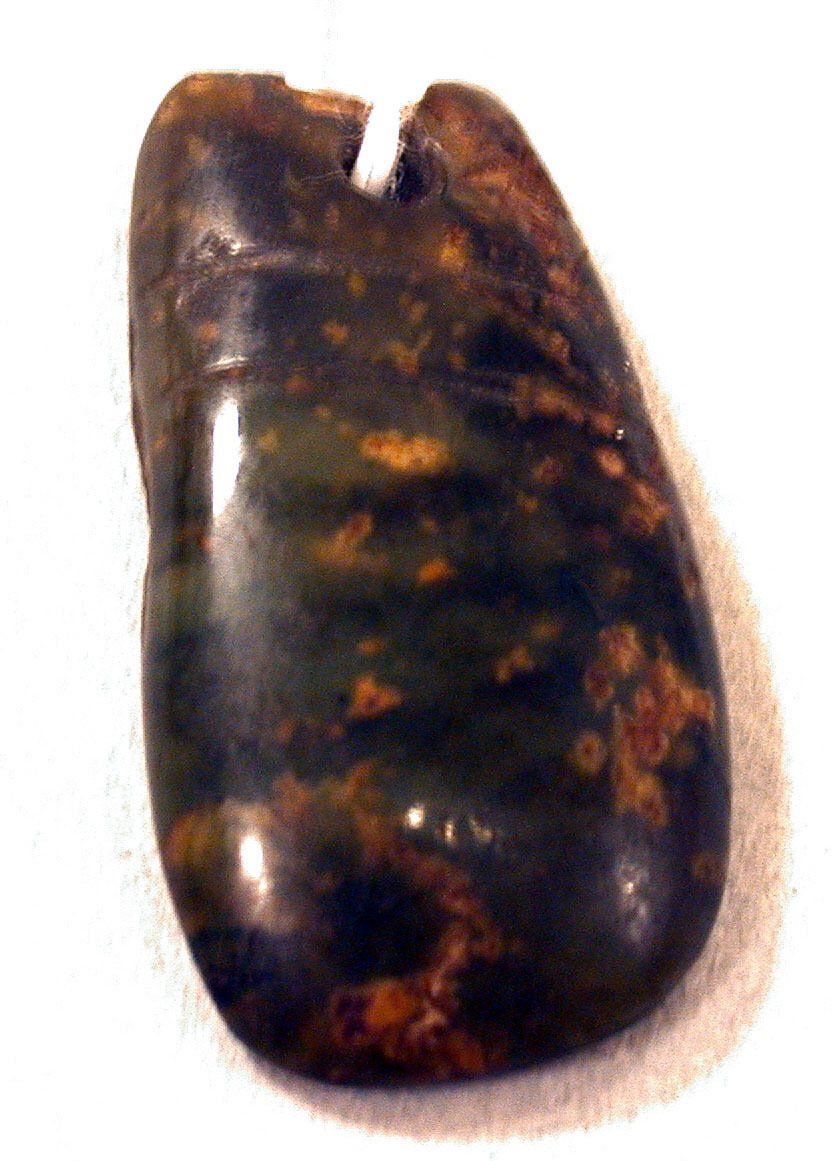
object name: pendant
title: Stone Pendant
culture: costa rican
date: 801-1500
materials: stone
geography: costa rica